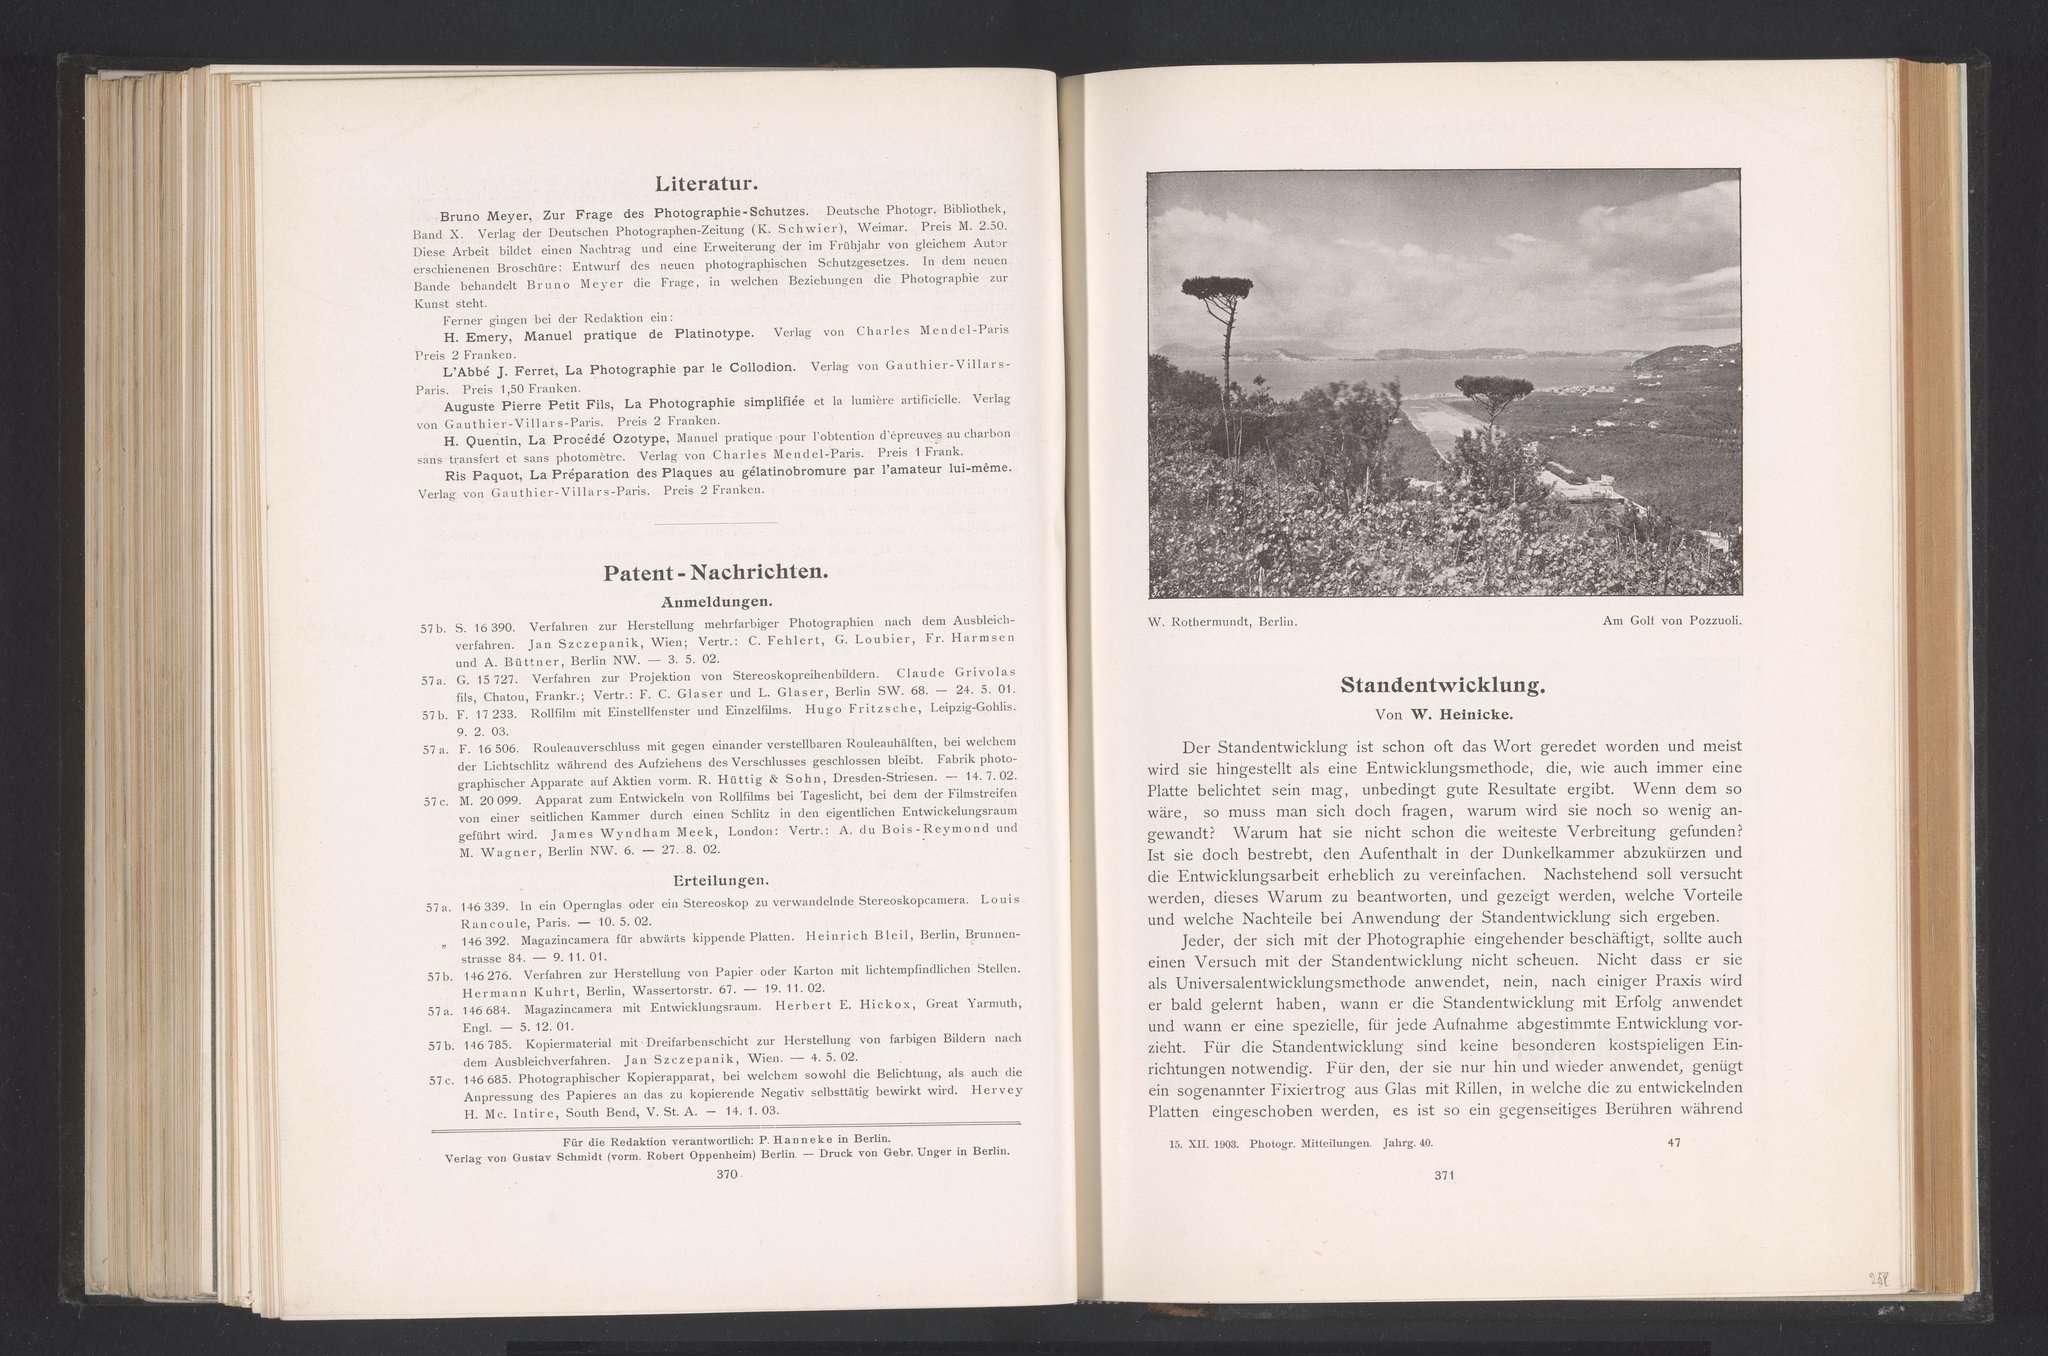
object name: page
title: Am Golf von Pozzuoli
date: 1898-1903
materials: paper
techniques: autotype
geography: pozzuoli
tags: gulf, bay, landscapes, pozzuoli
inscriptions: monogram: ‘BX’